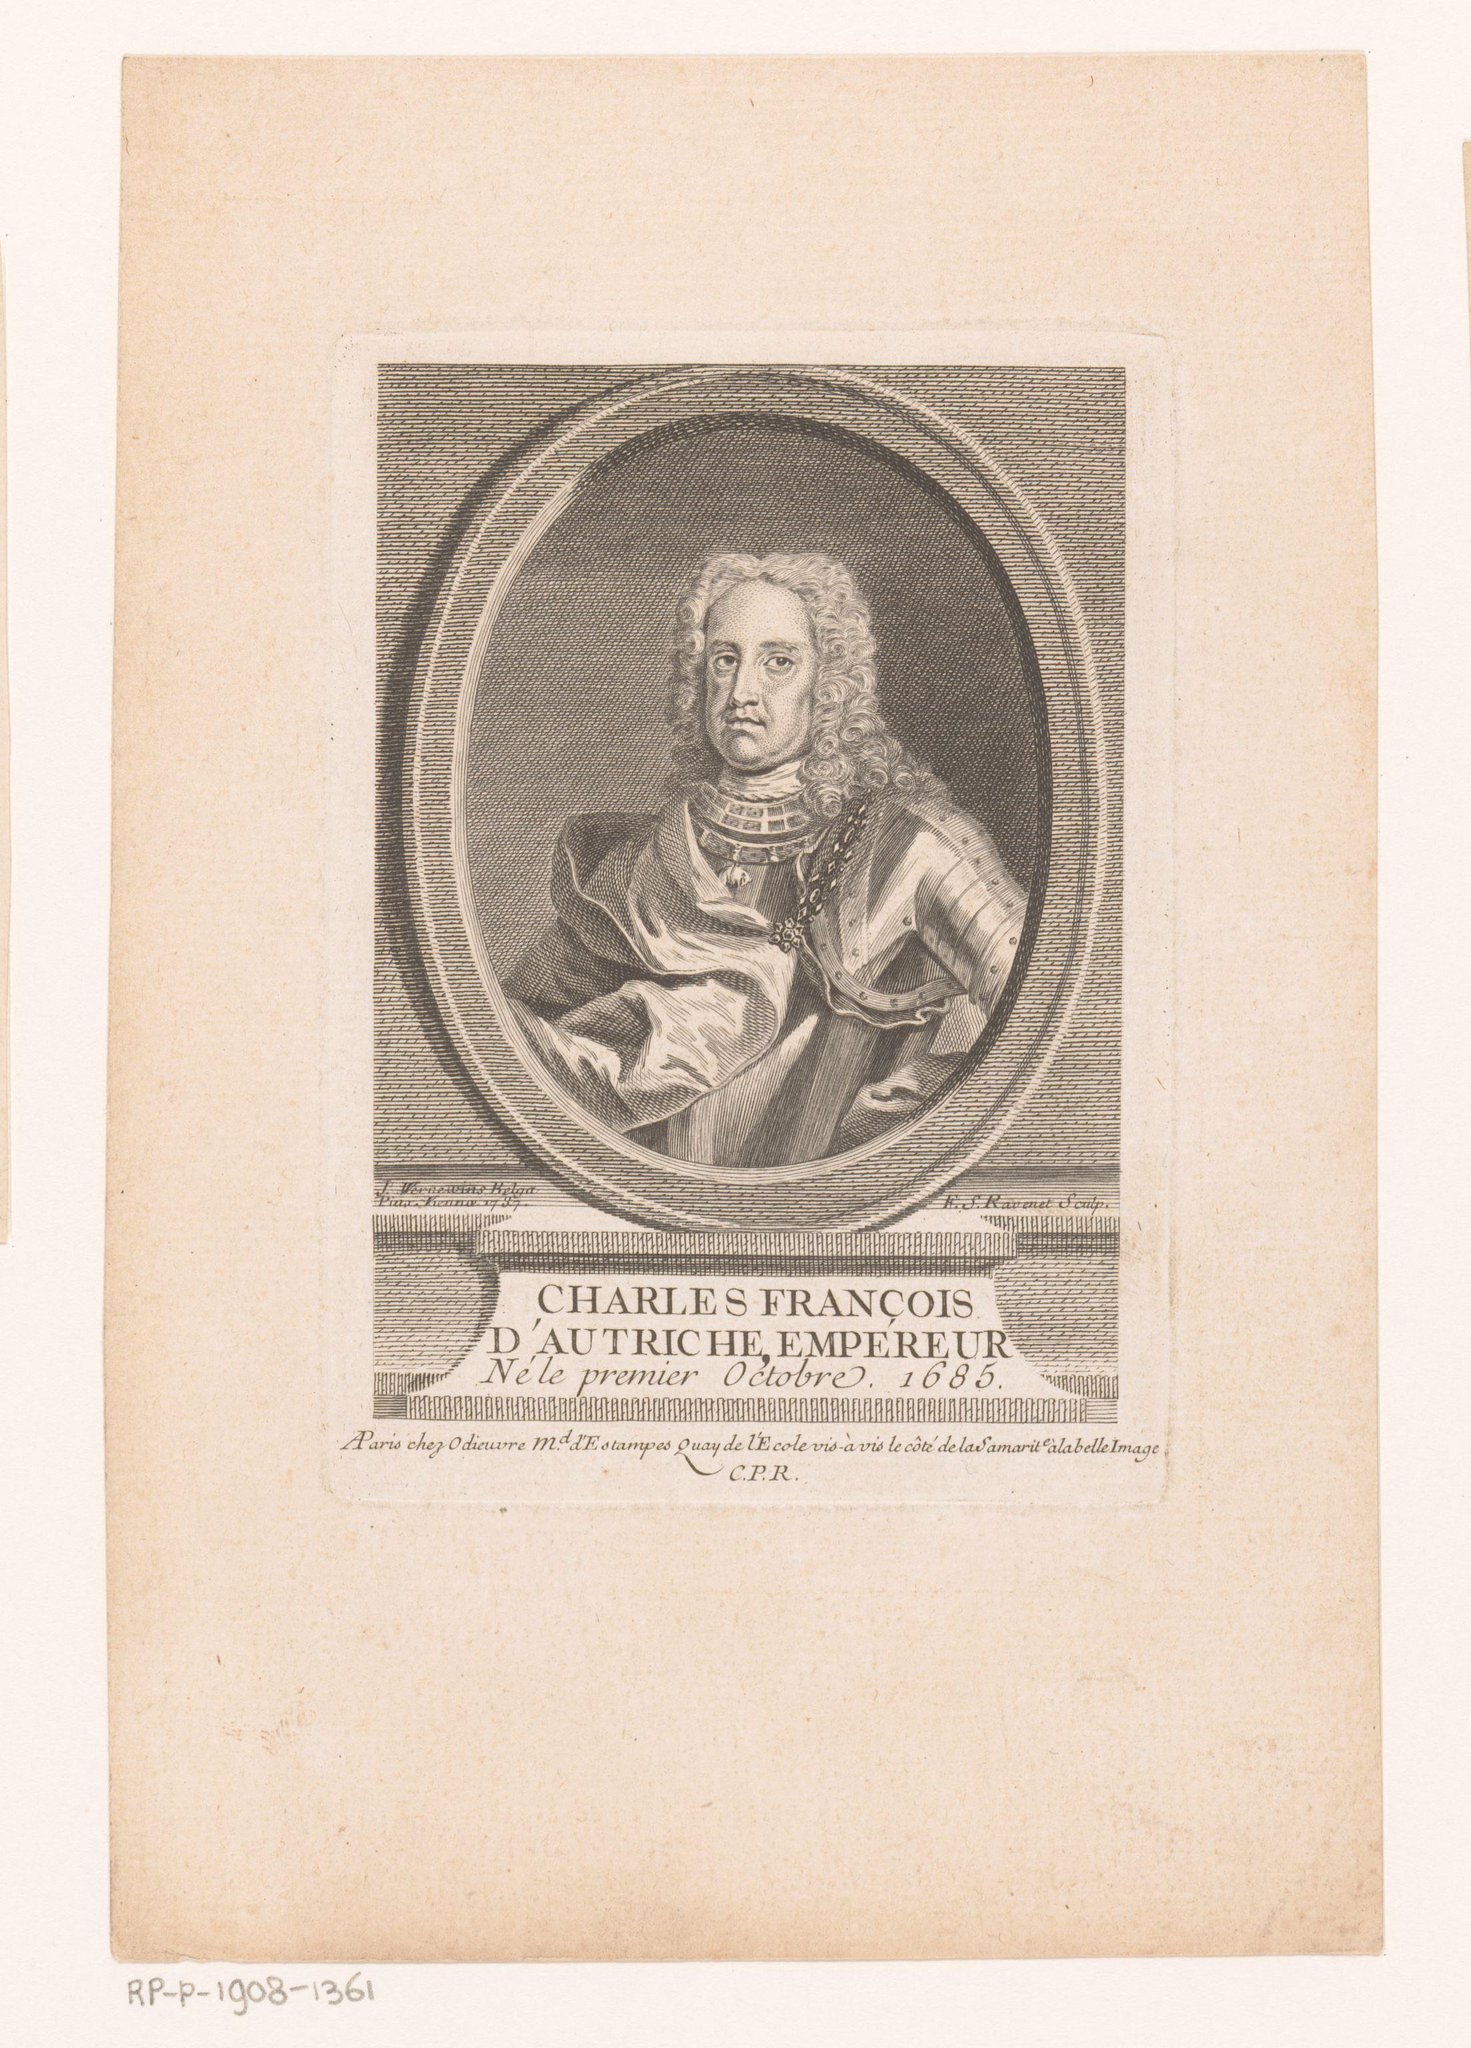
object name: print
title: Charles François d'Autriche, Empereur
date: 1716-1740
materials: paper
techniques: engraving, etching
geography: france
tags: vienna, charles vi (holy roman emperor), historical persons, emperor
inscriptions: collector's mark: Lugt 2228